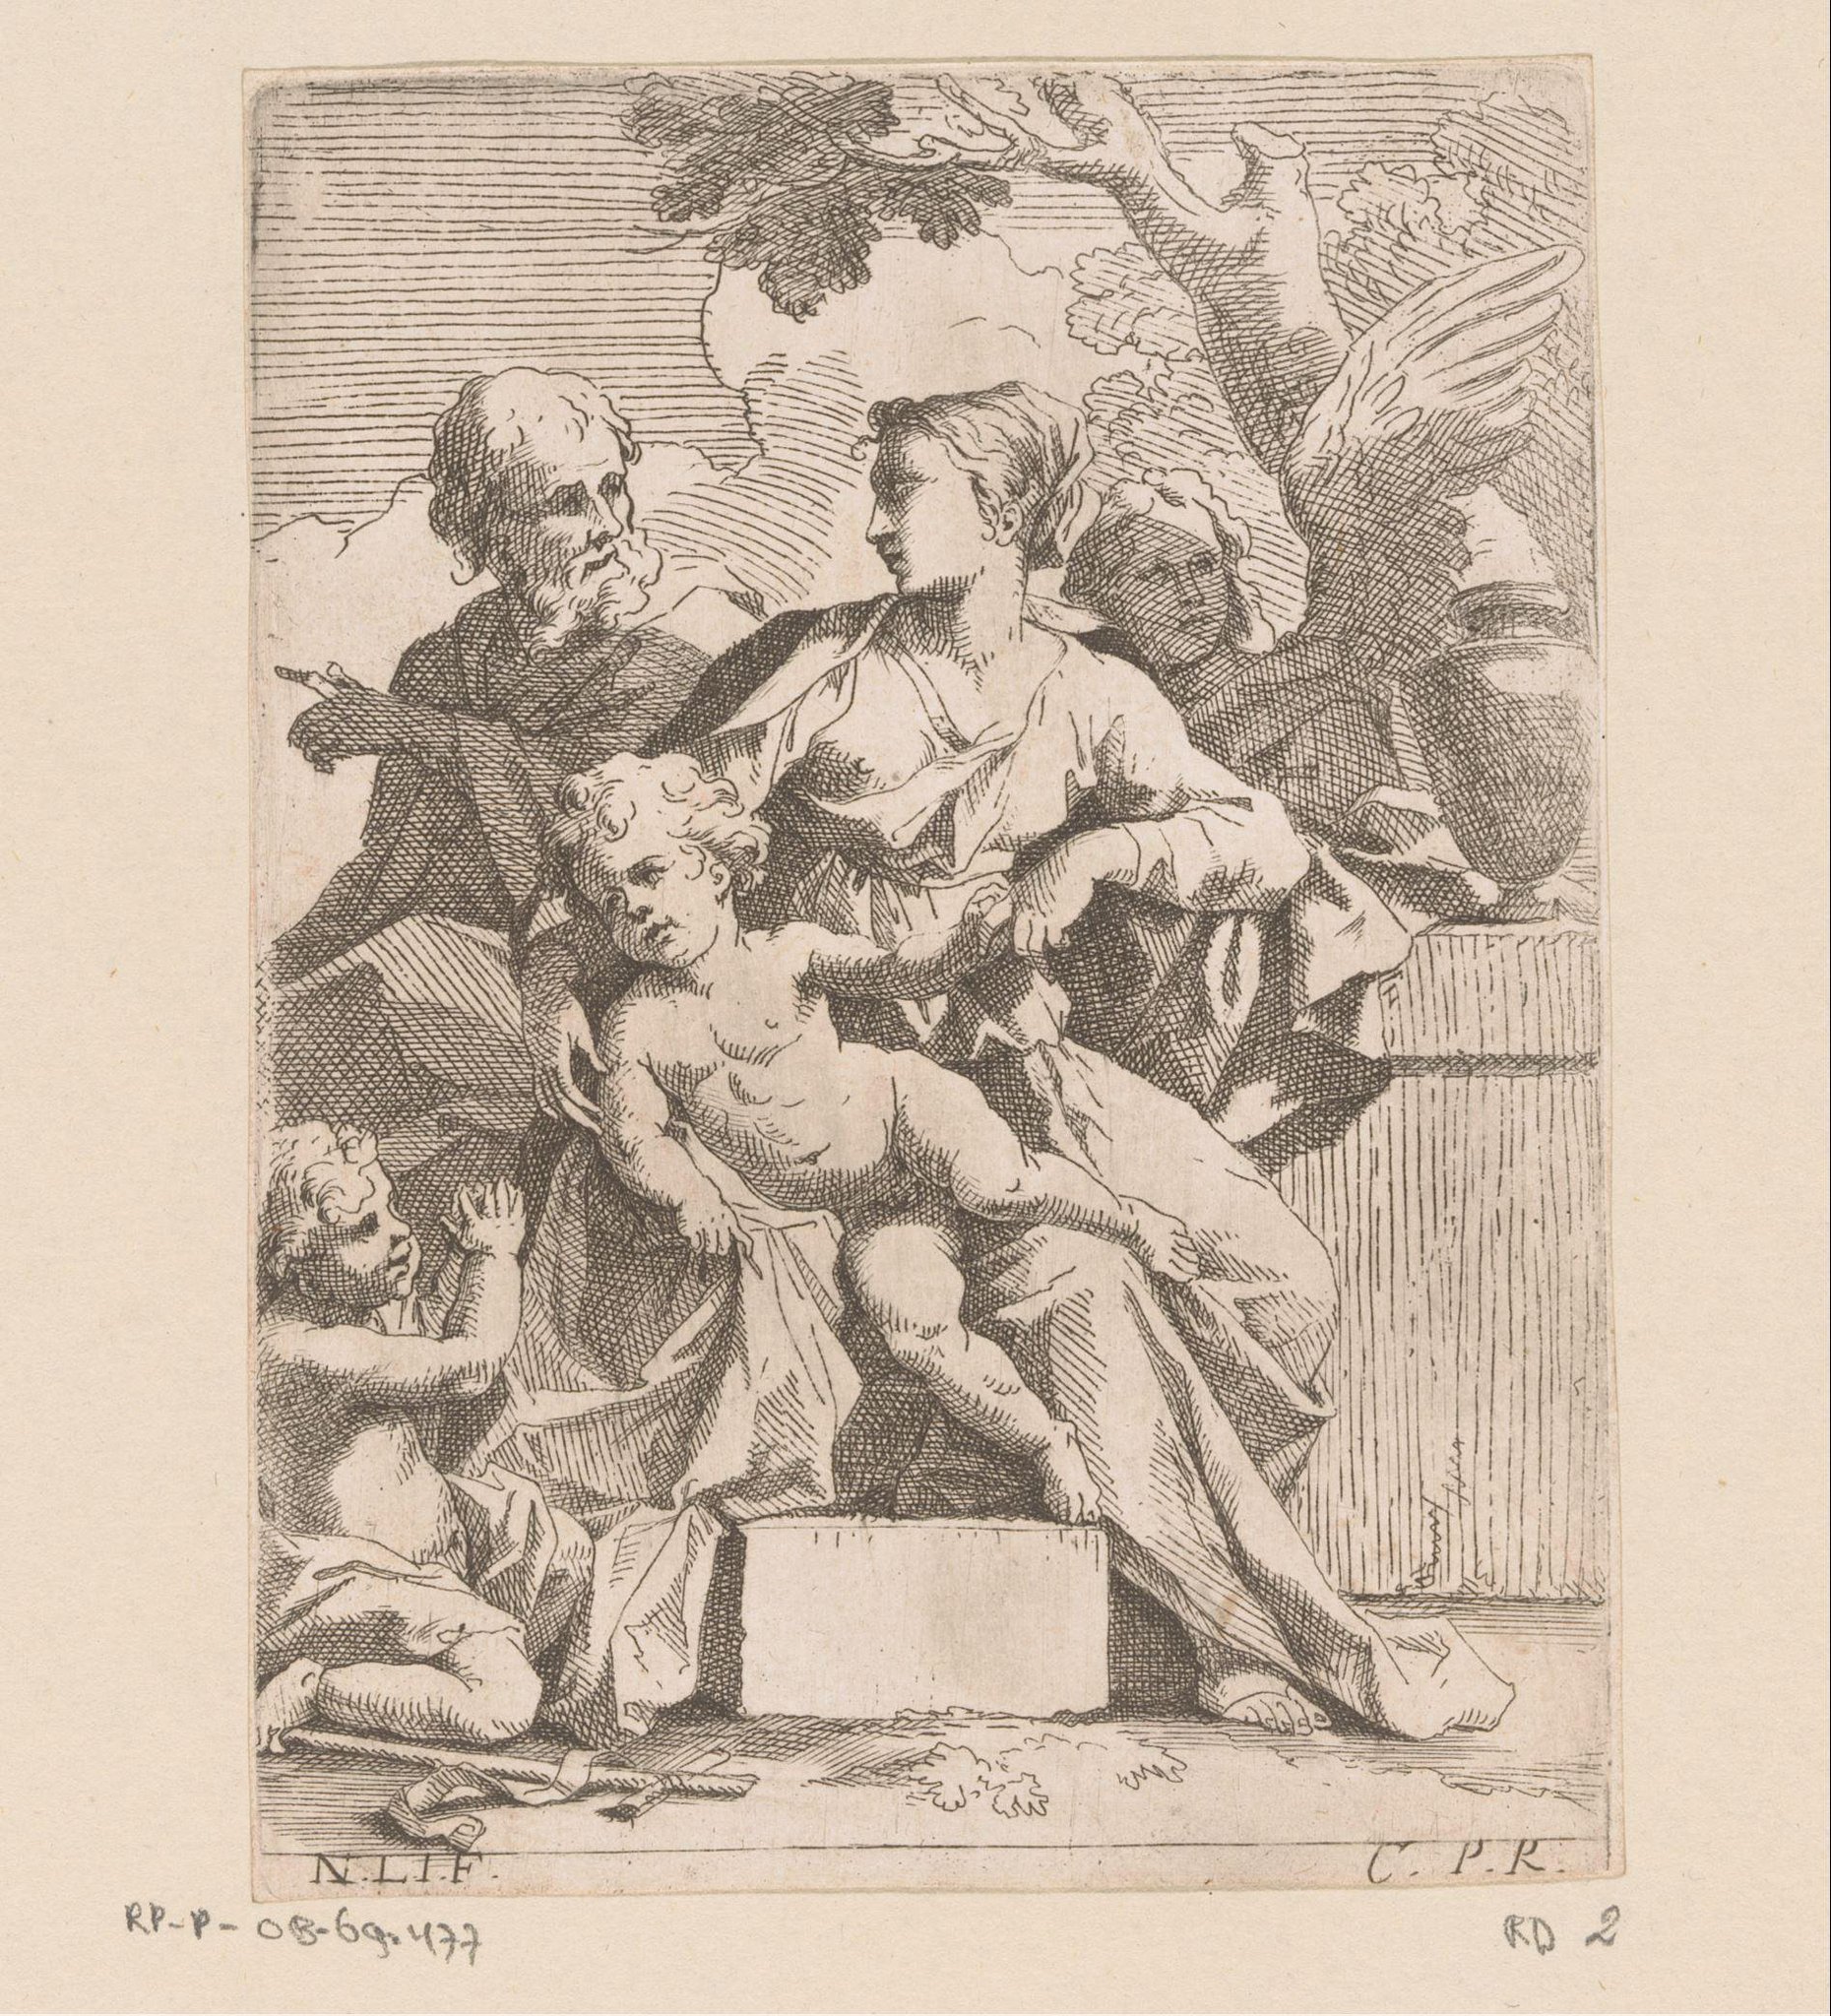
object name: print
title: Heilige families en Maria met kind en Johannes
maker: nicolas pierre loir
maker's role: painter, print maker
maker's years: 1624-1679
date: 1634-1679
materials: paper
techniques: etching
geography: france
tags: holy family, and derived representations (+ angel(s))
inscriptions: collector's mark: Lugt 240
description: Maakt deel uit van een twaalfdelige serie met Heilige families en afbeeldingen van Maria met kind en Johannes de Doper.